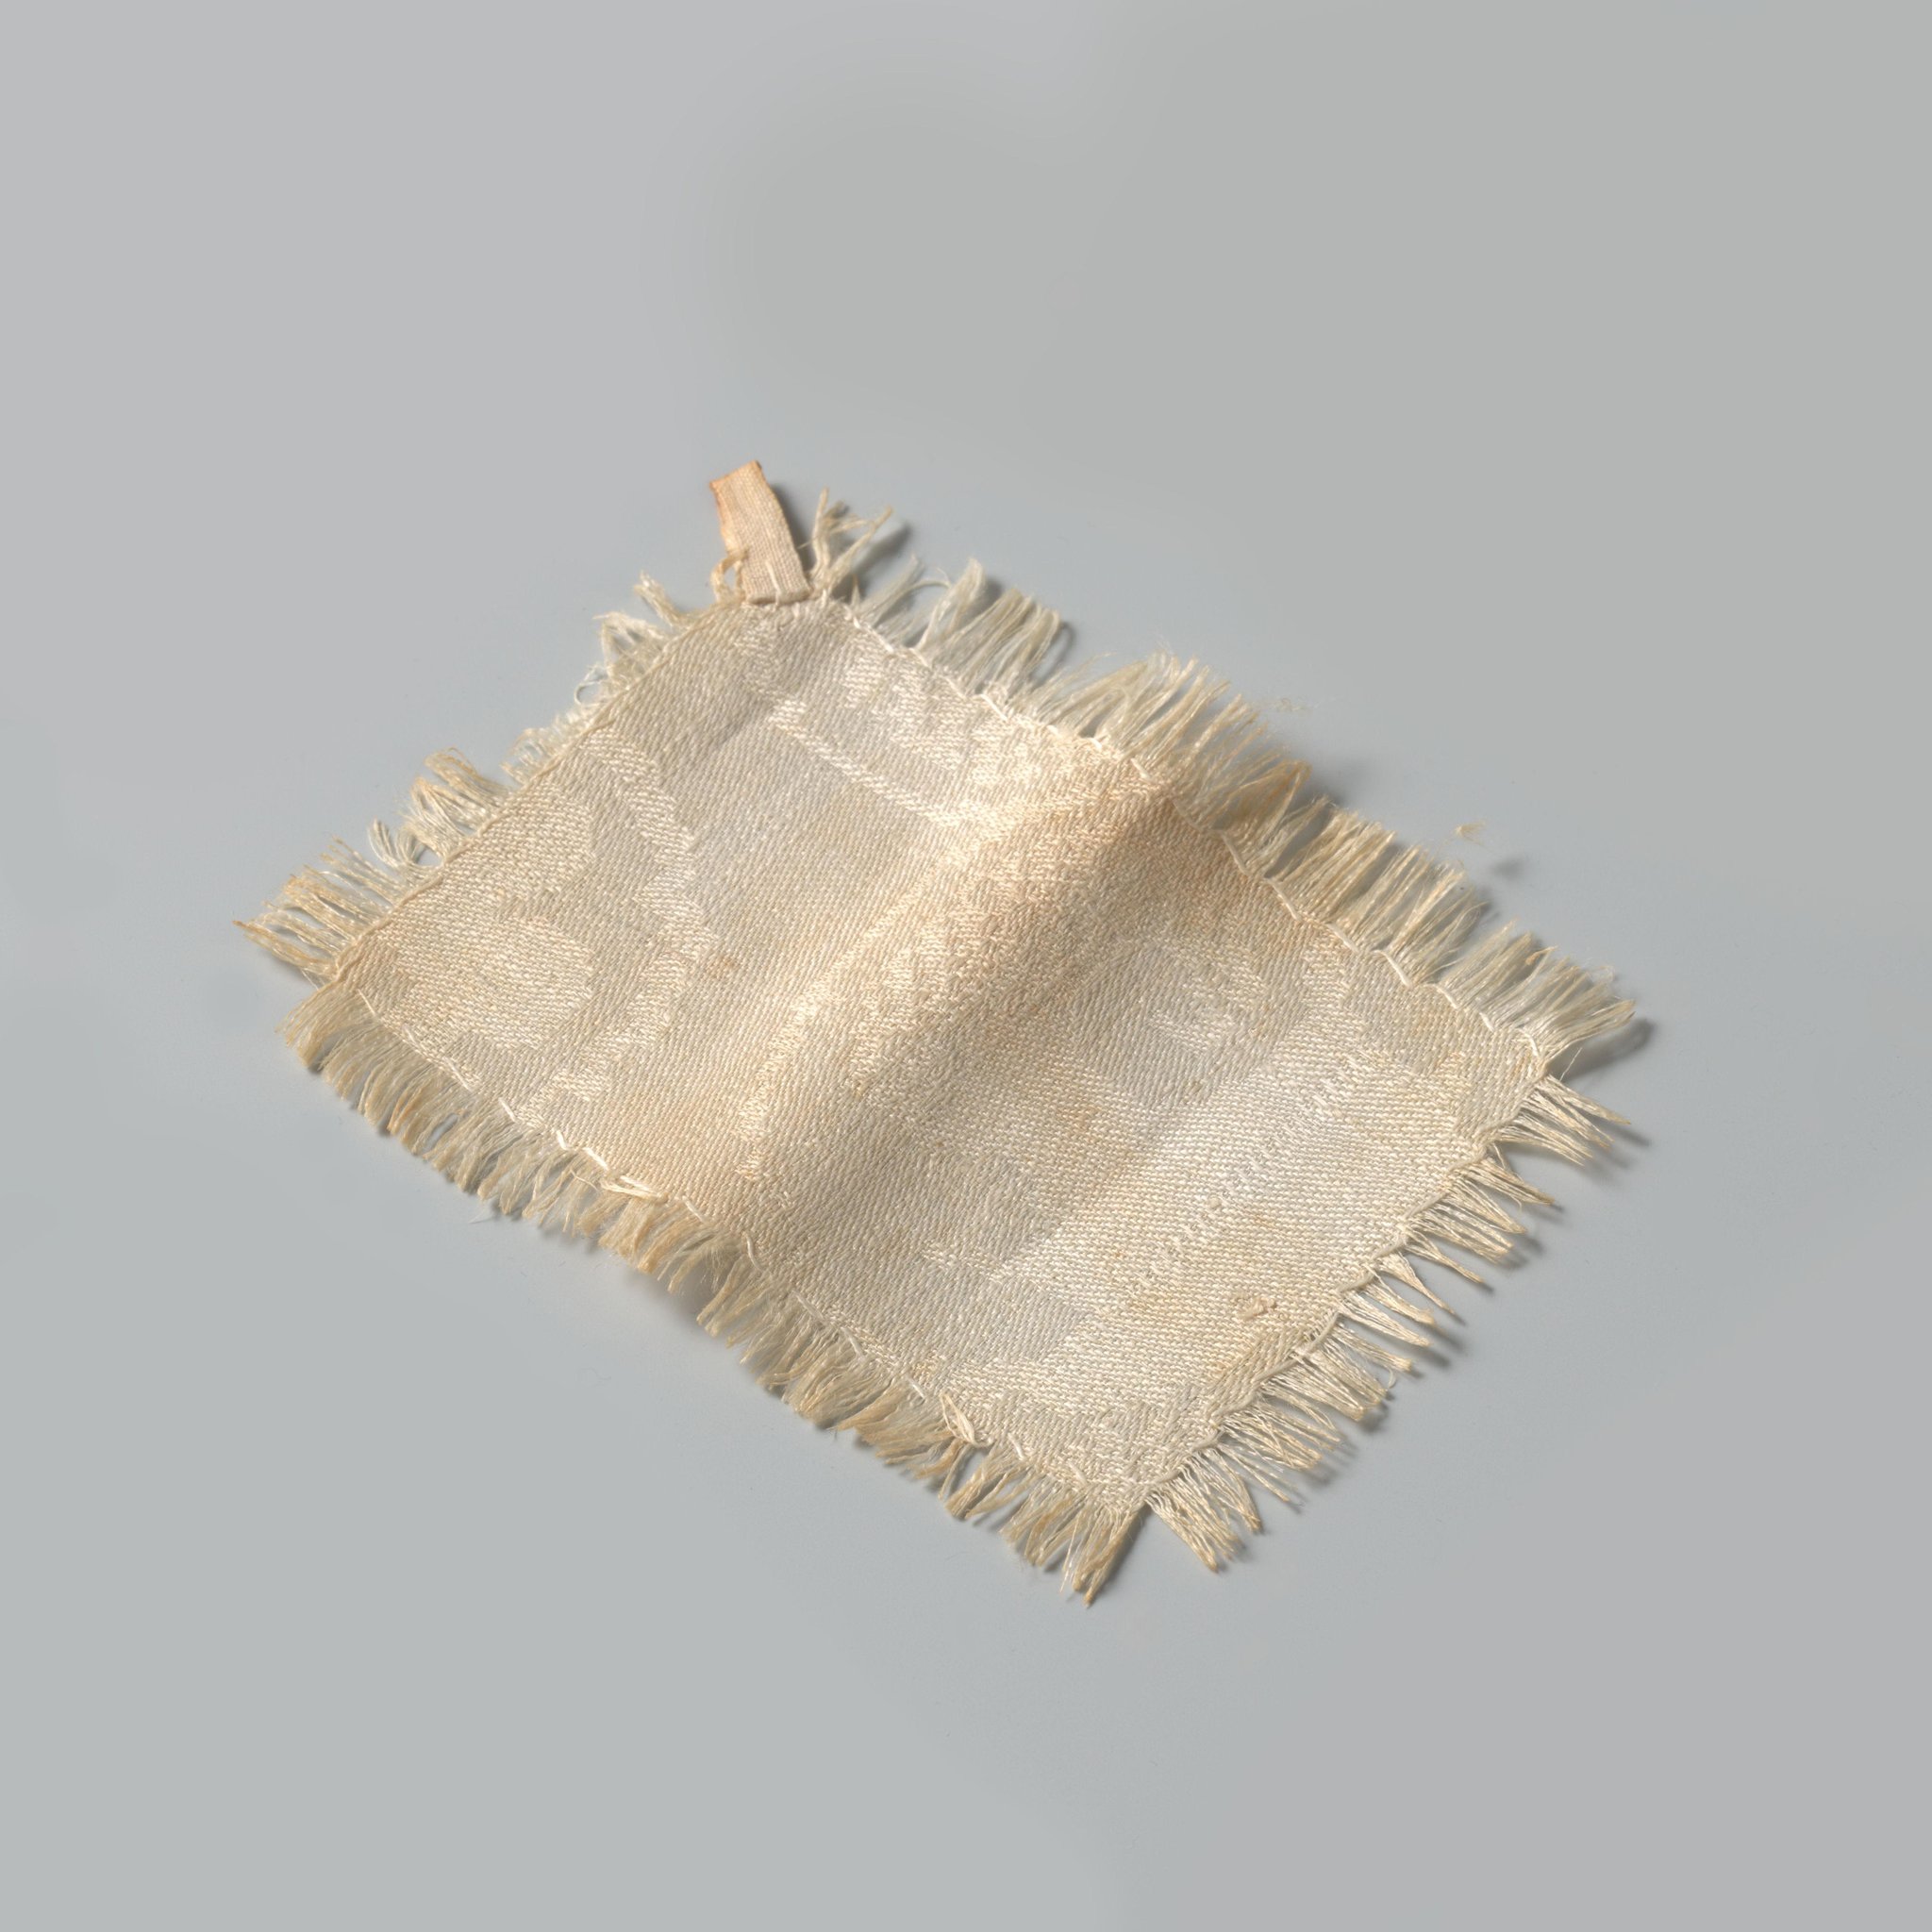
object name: miniature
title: Handdoek, linnendamast, met bloemmoetief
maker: Anonymous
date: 1676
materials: linen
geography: netherlands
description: Handdoek, vervaardigd van linnendamast, met bloemmotief, geknipt uit een groot servet met bloemen (niet identificeerbaar). Randen bijna één centimeter bewust uitgerafeld.